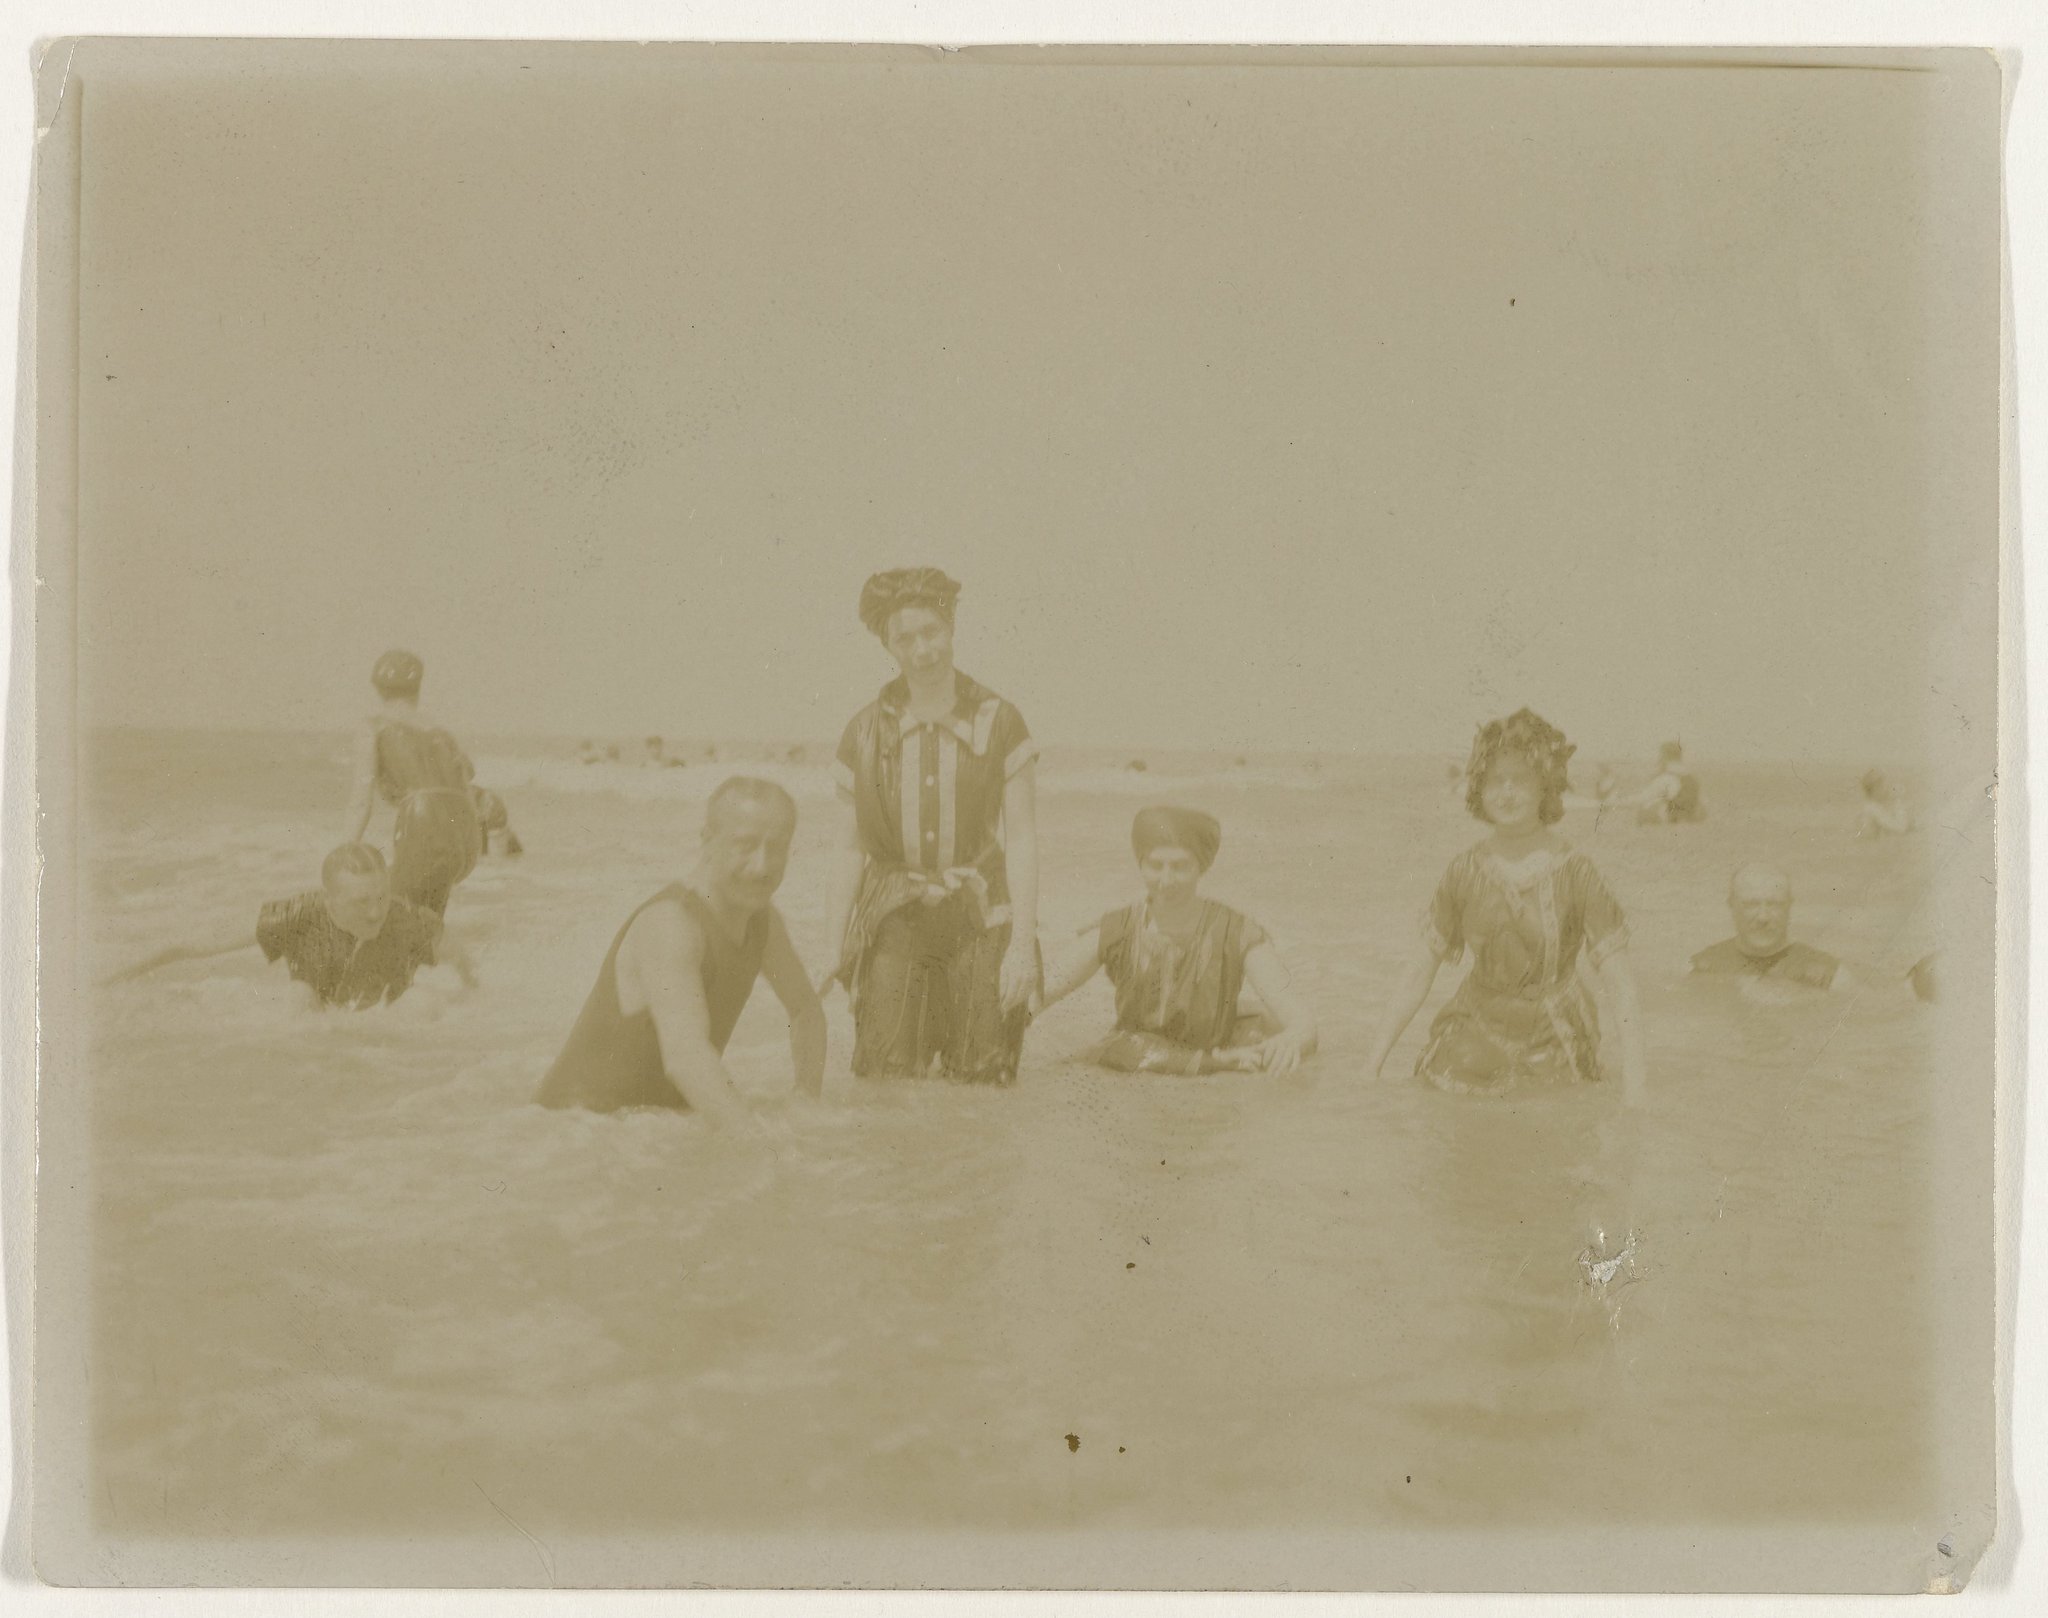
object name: photograph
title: Groepsportret van mensen in zee (Noordzeekust), Nederland of Duitsland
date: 1900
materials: paper, photographic support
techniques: gelatin silver print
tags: beach (as place of recreation), netherlands, germany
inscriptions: annotation: ‘fot [?] Lensing [?] // 3 // 12’